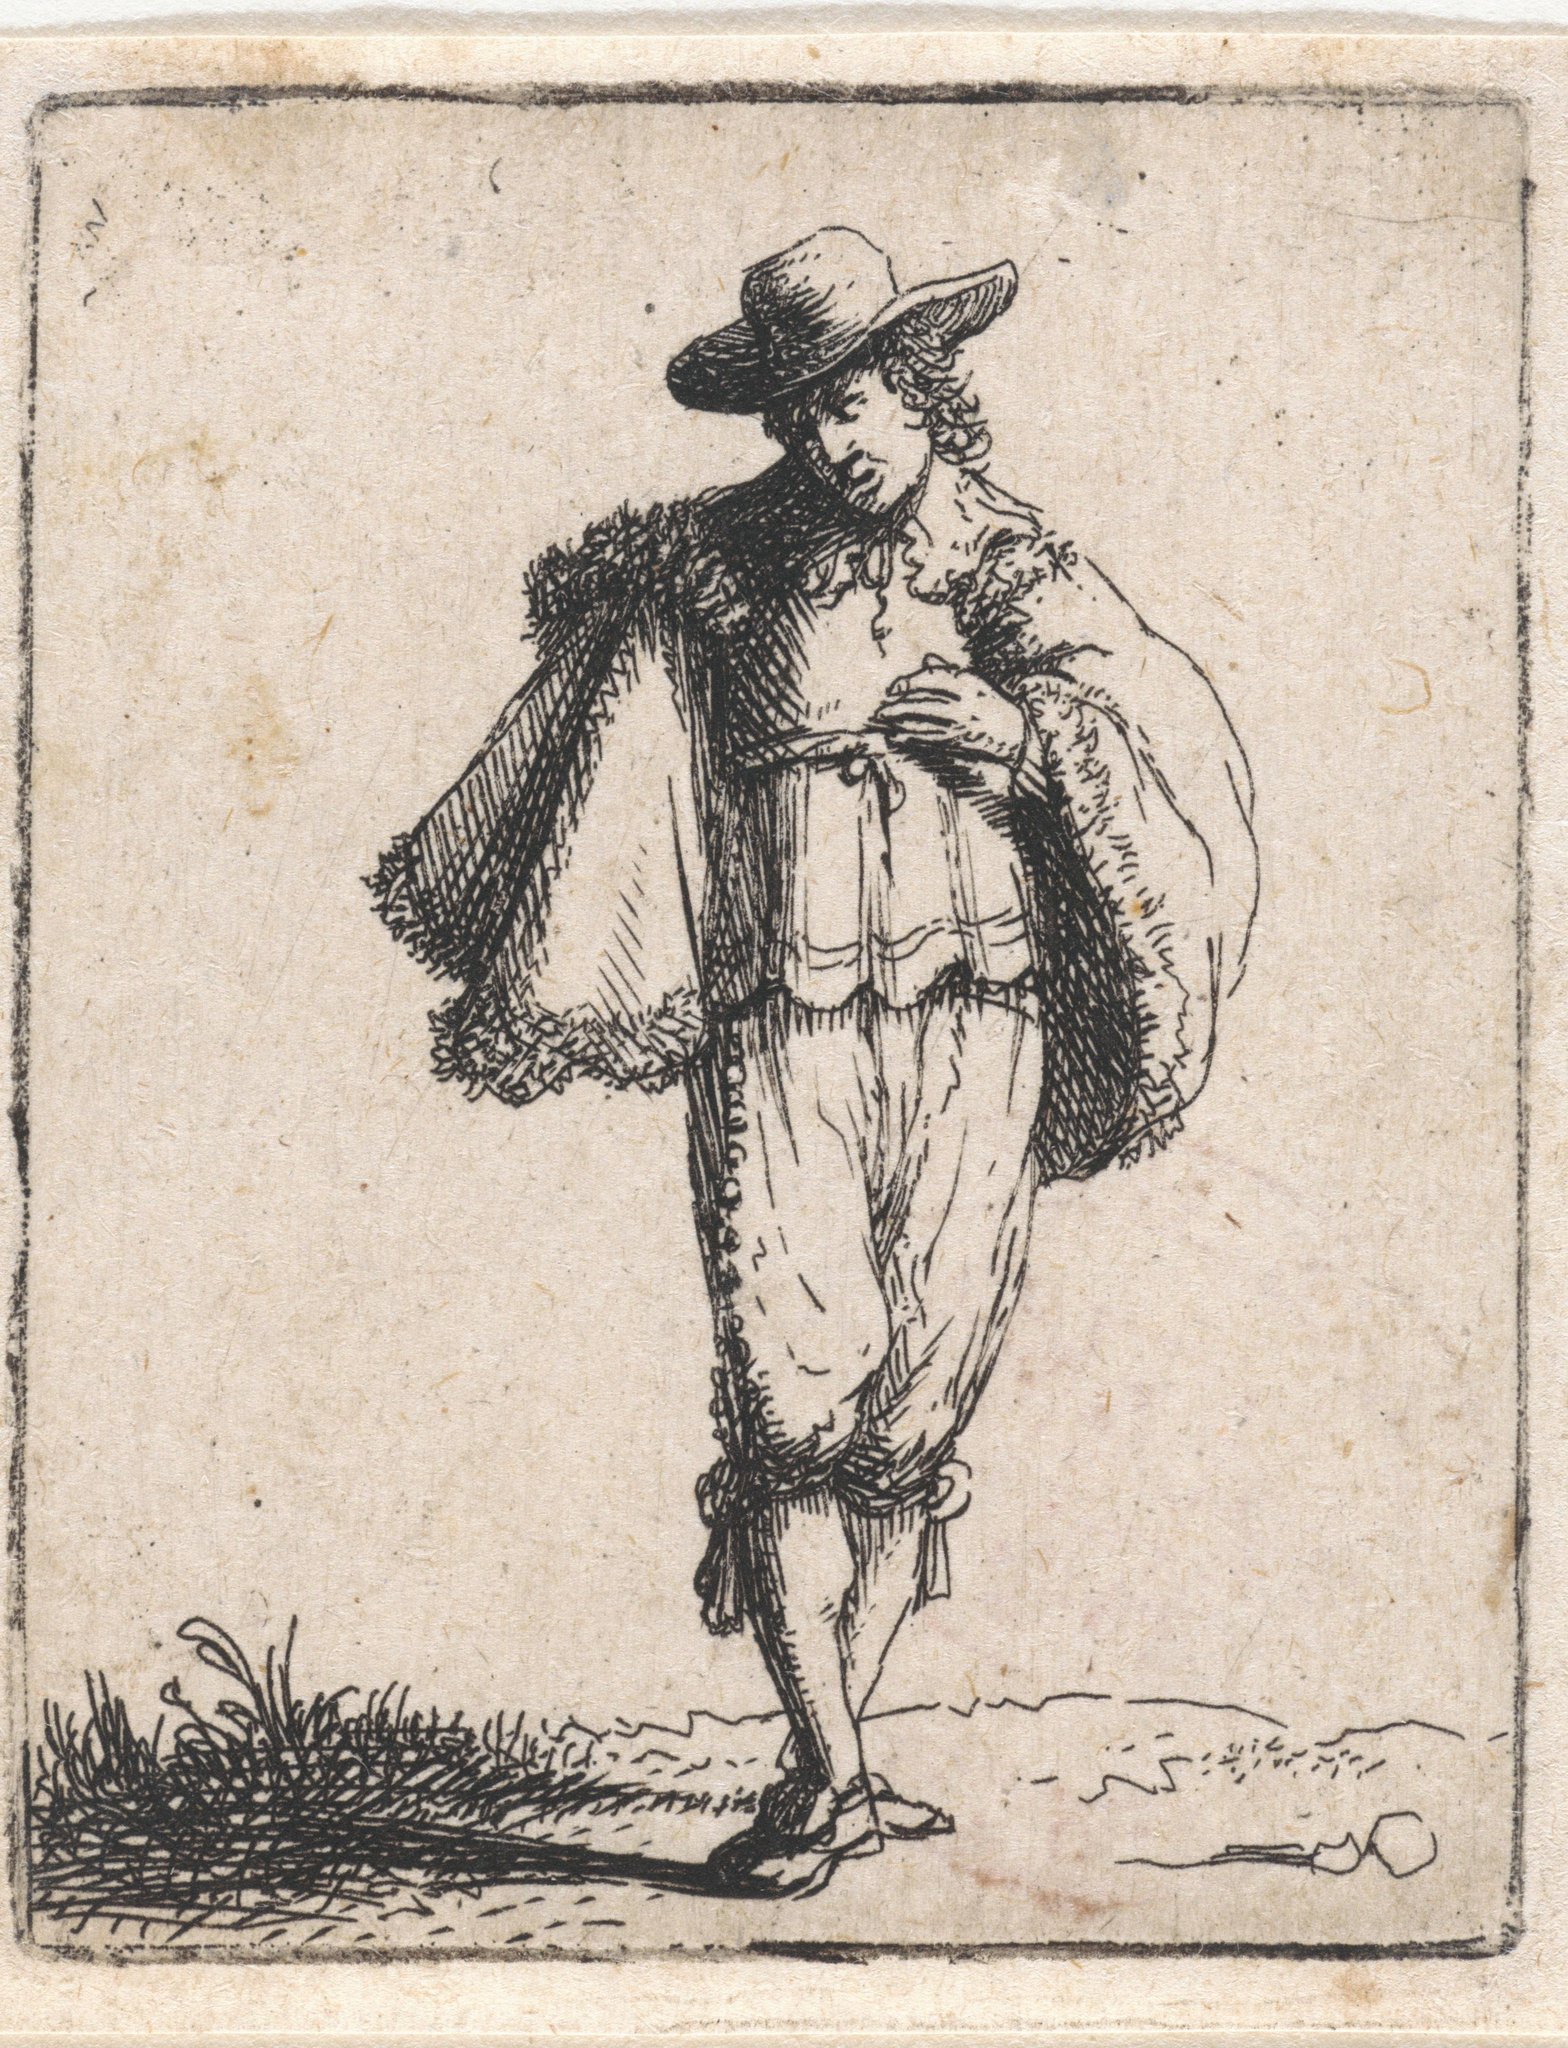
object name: print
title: Man met cape en hoed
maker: jan gillisz. van vliet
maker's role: draughtsman, painter, print maker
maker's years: 1600-1668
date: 1632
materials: paper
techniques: etching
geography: leiden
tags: clothing for the upper part of the body (with name) (+ men's clothes), cape (+ fur used for clothes), head-gear: hat (+ men's clothes), shoes, sandals (+ men's clothes), trousers, breeches, etc. (breeches) (+ men's clothes), clothing for the upper part of the body (doublet) (+ men's clothes), netherlands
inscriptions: collector's mark: Lugt 240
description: Een elegant geklede man draagt een met bont gevoerde korte schoudermantel en op zijn hoofd een hoed met een rand.